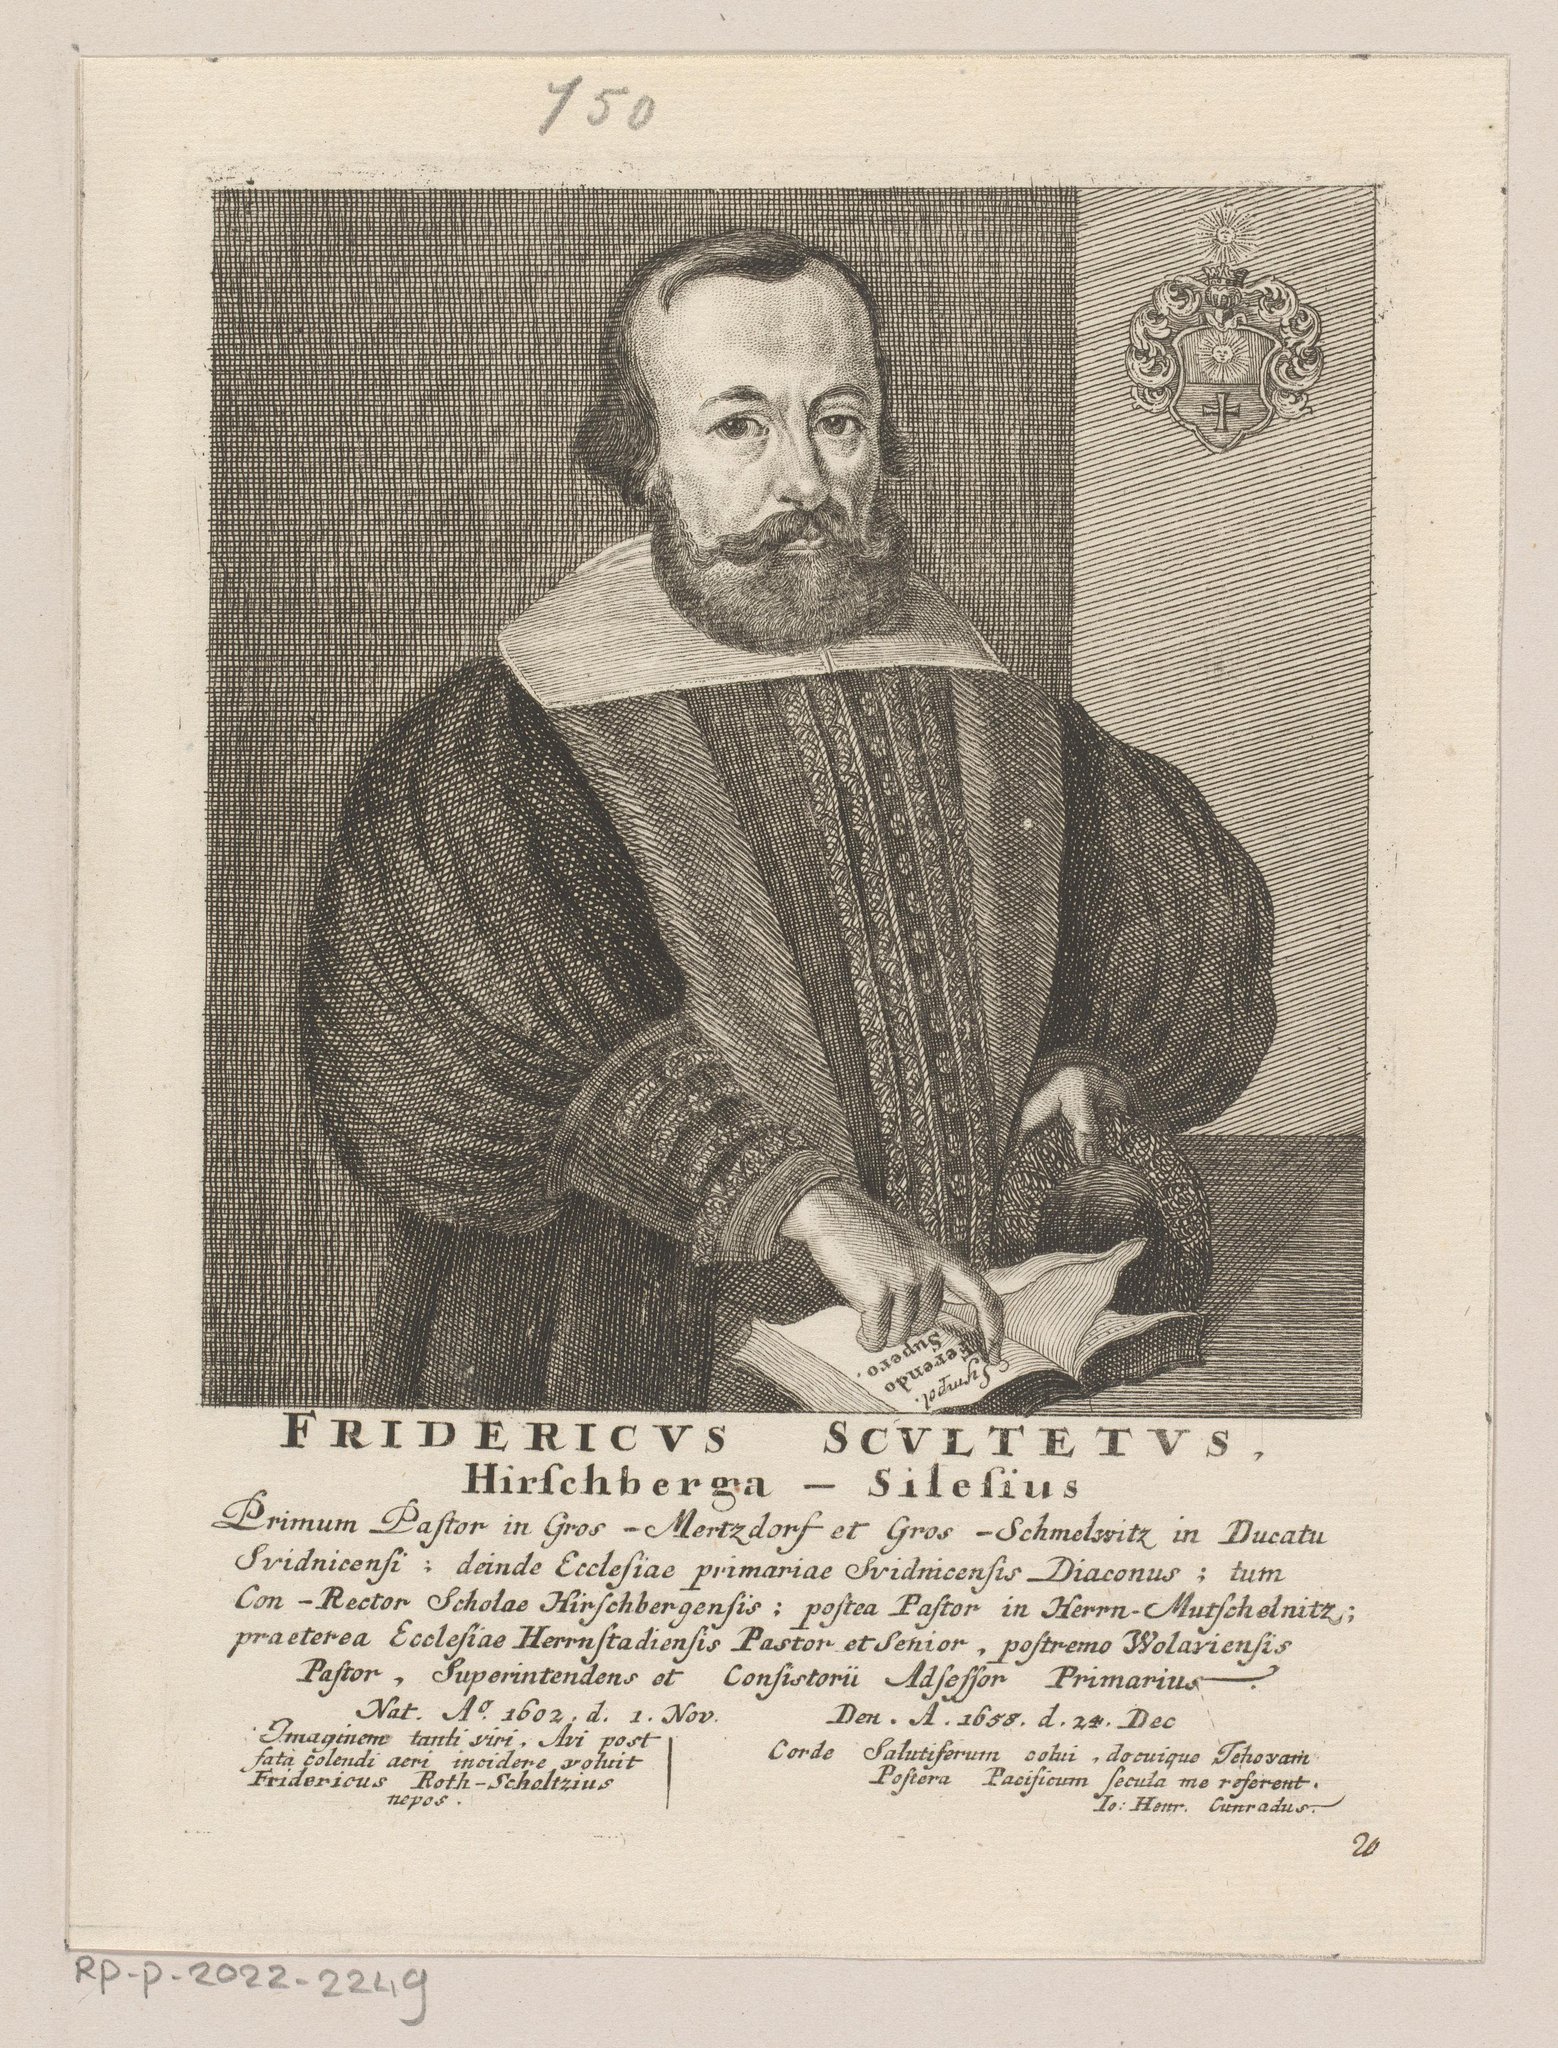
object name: print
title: Portret van Friedrich Scultetus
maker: fridericus roth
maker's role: print maker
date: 1725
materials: paper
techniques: engraving, etching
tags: theologian, historical persons, armorial bearing, heraldry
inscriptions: number: ‘20’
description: Prent waarschijnlijk uit: Rothscholtz, Friedrich. Icones virorum omnium ordinum eruditione: omnique item genere et varietate artium de republica litteraria et speciatim de Academiis et Gymnasiis (...). Neurenberg: erven Johann Daniel Tauber, 1725, dl. 1 of 2.